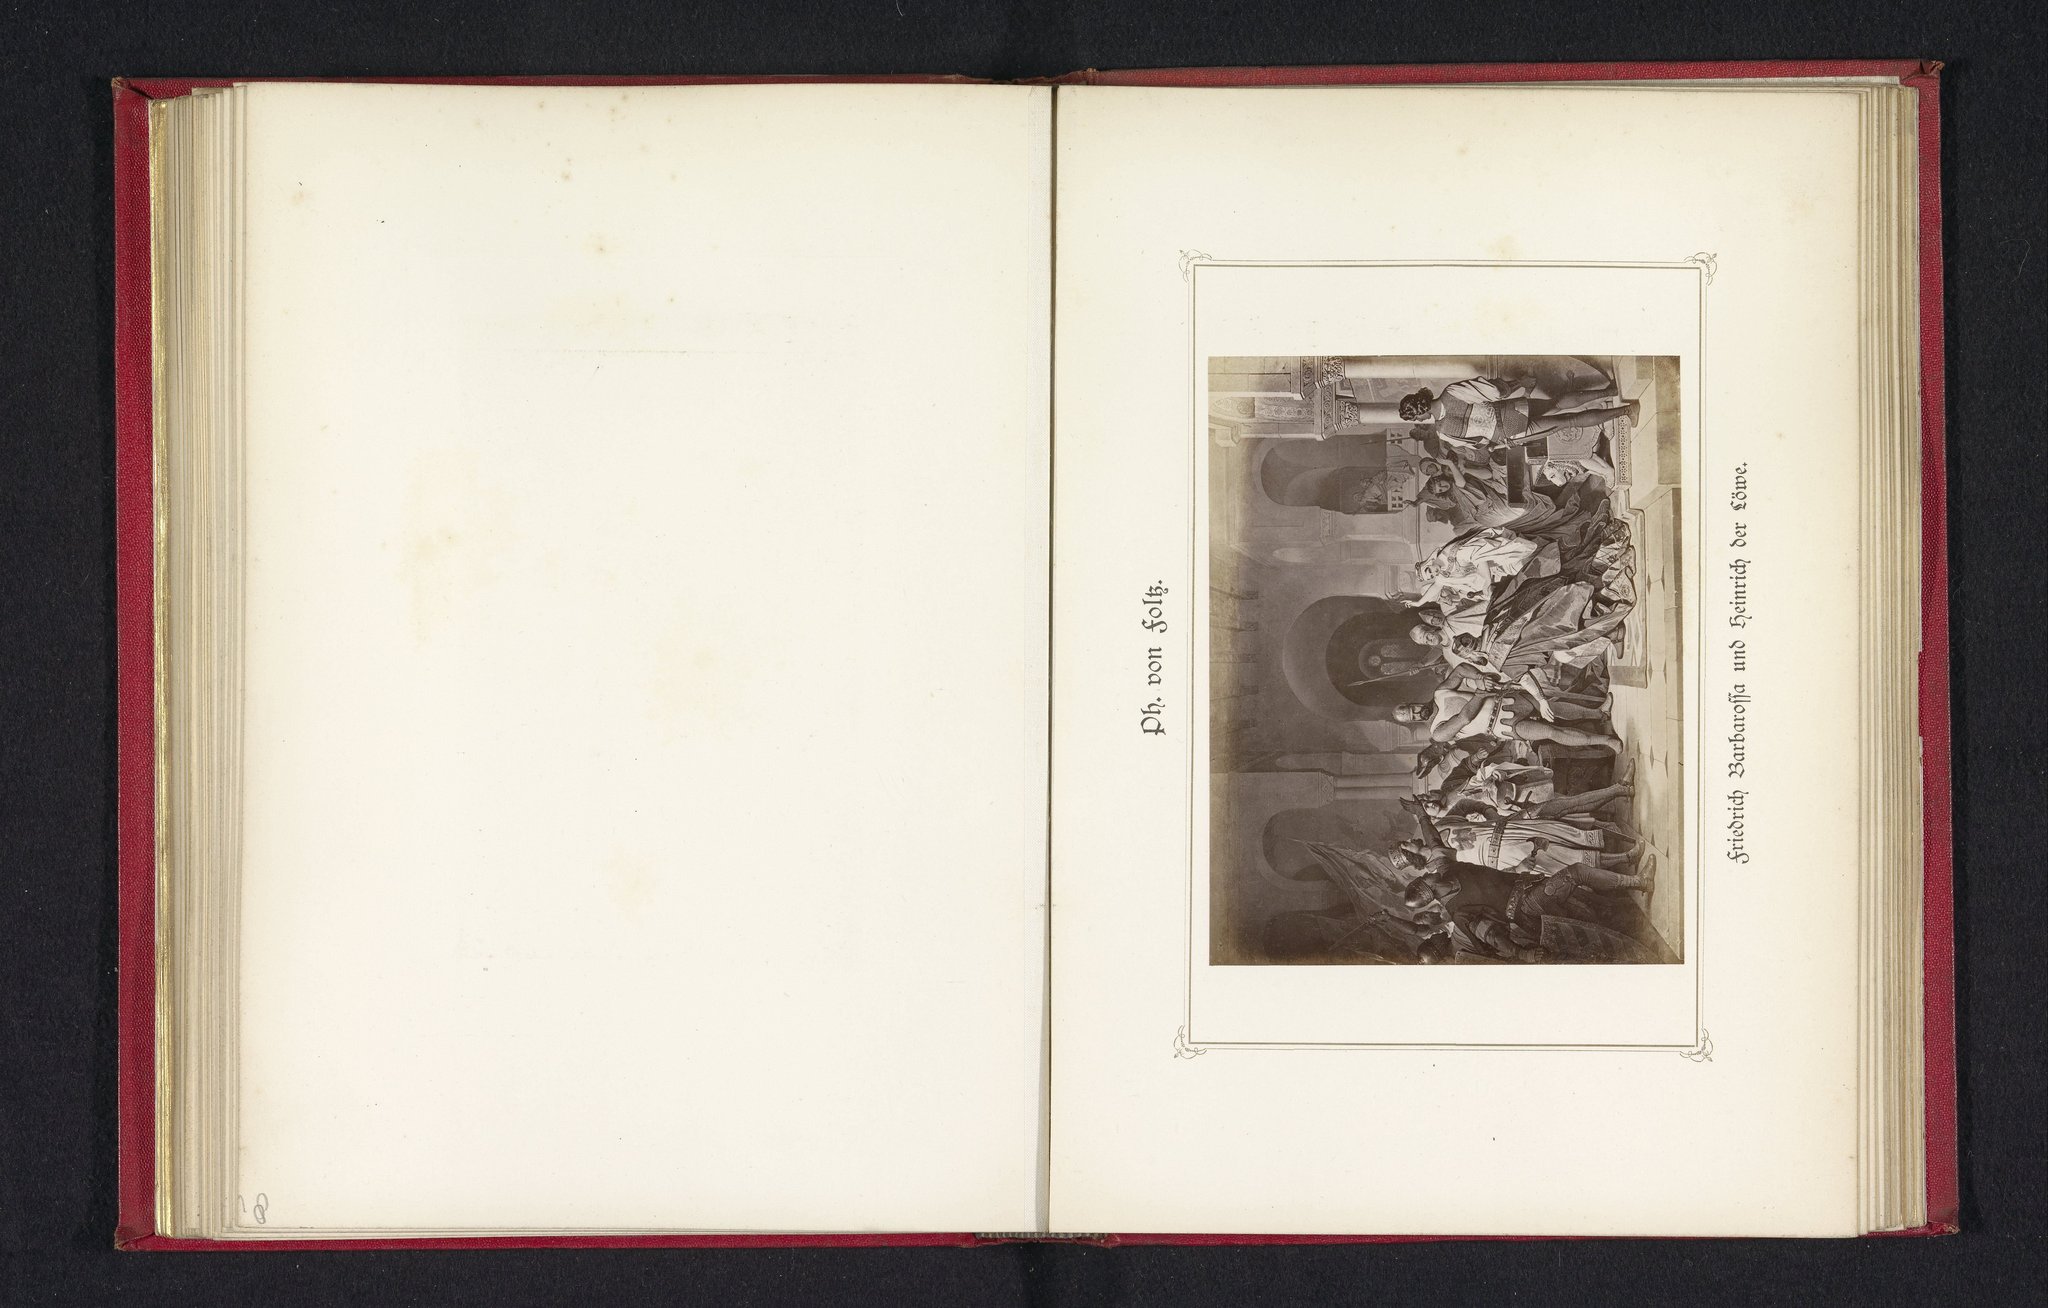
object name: photograph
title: Friedrich Barbarossa und Heinrich der Löwe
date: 1875-1880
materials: photographic support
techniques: albumen print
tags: emperor, ruler, sovereign